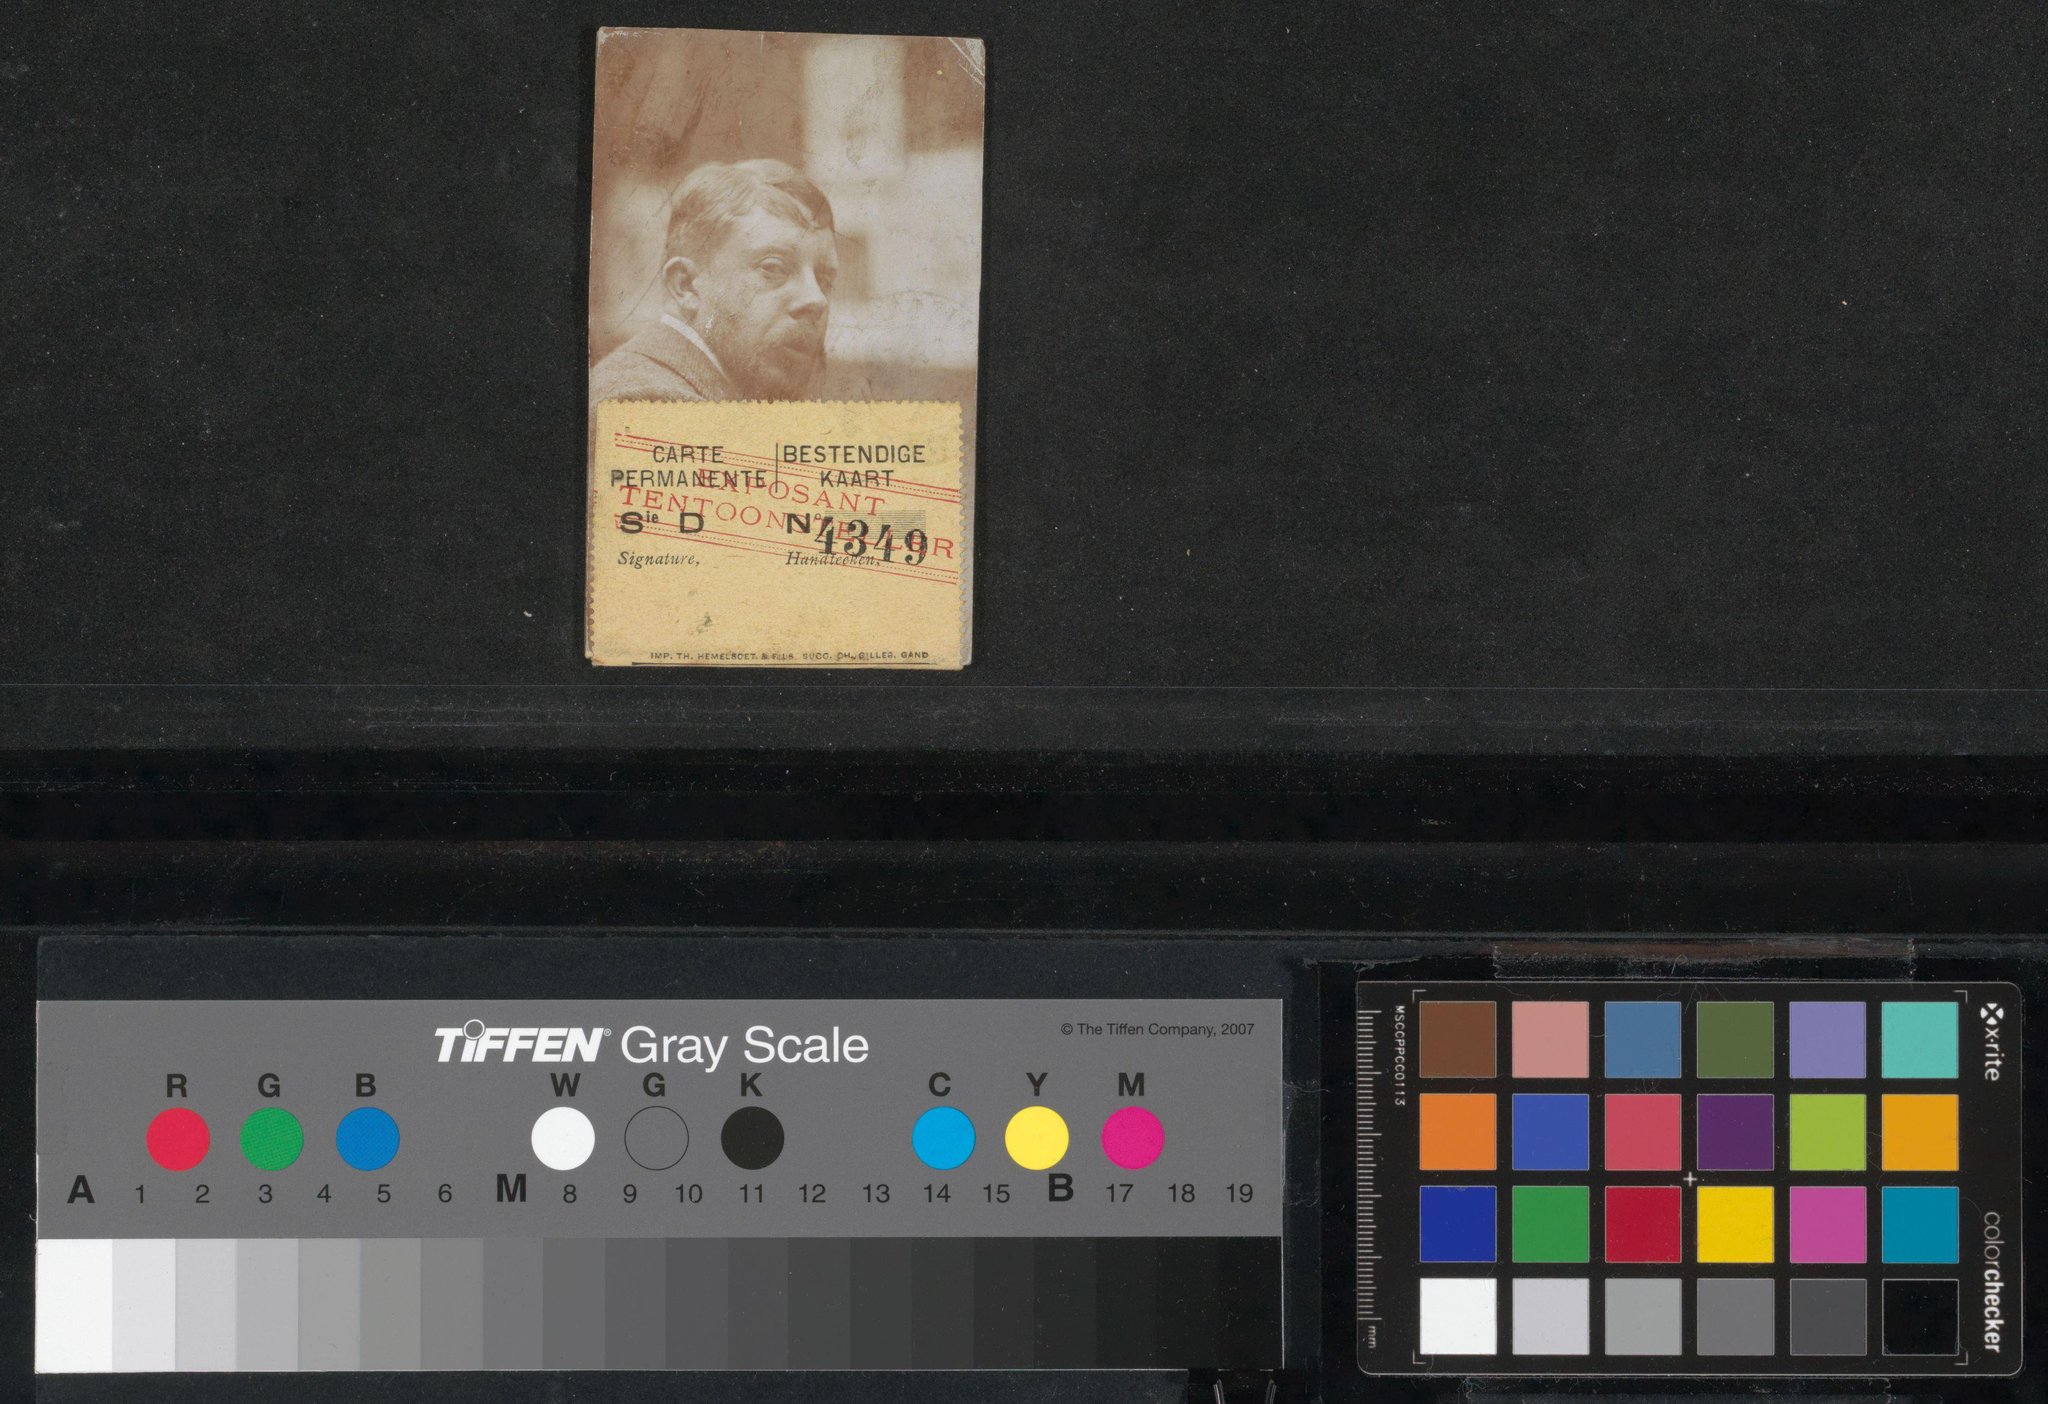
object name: document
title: Carte permanente van George Hendrik Breitner voor de wereldtentoonstelling in Gent in 1913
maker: Anonymous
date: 1913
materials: cardboard, paper, photographic support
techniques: collodion silver print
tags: amsterdam, painter, print maker, draughtsman, george hendrik breitner, historical persons, portrait, self-portrait of artist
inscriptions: inscription: ‘1913 Gand/ exposition universelle/ carte permantente/ Mr. Breitner’, inscription: ‘[...]’, inscription: ‘Carte permanante/ Bestendige kaar/ exposant/ tentoonsteller/ N4349’